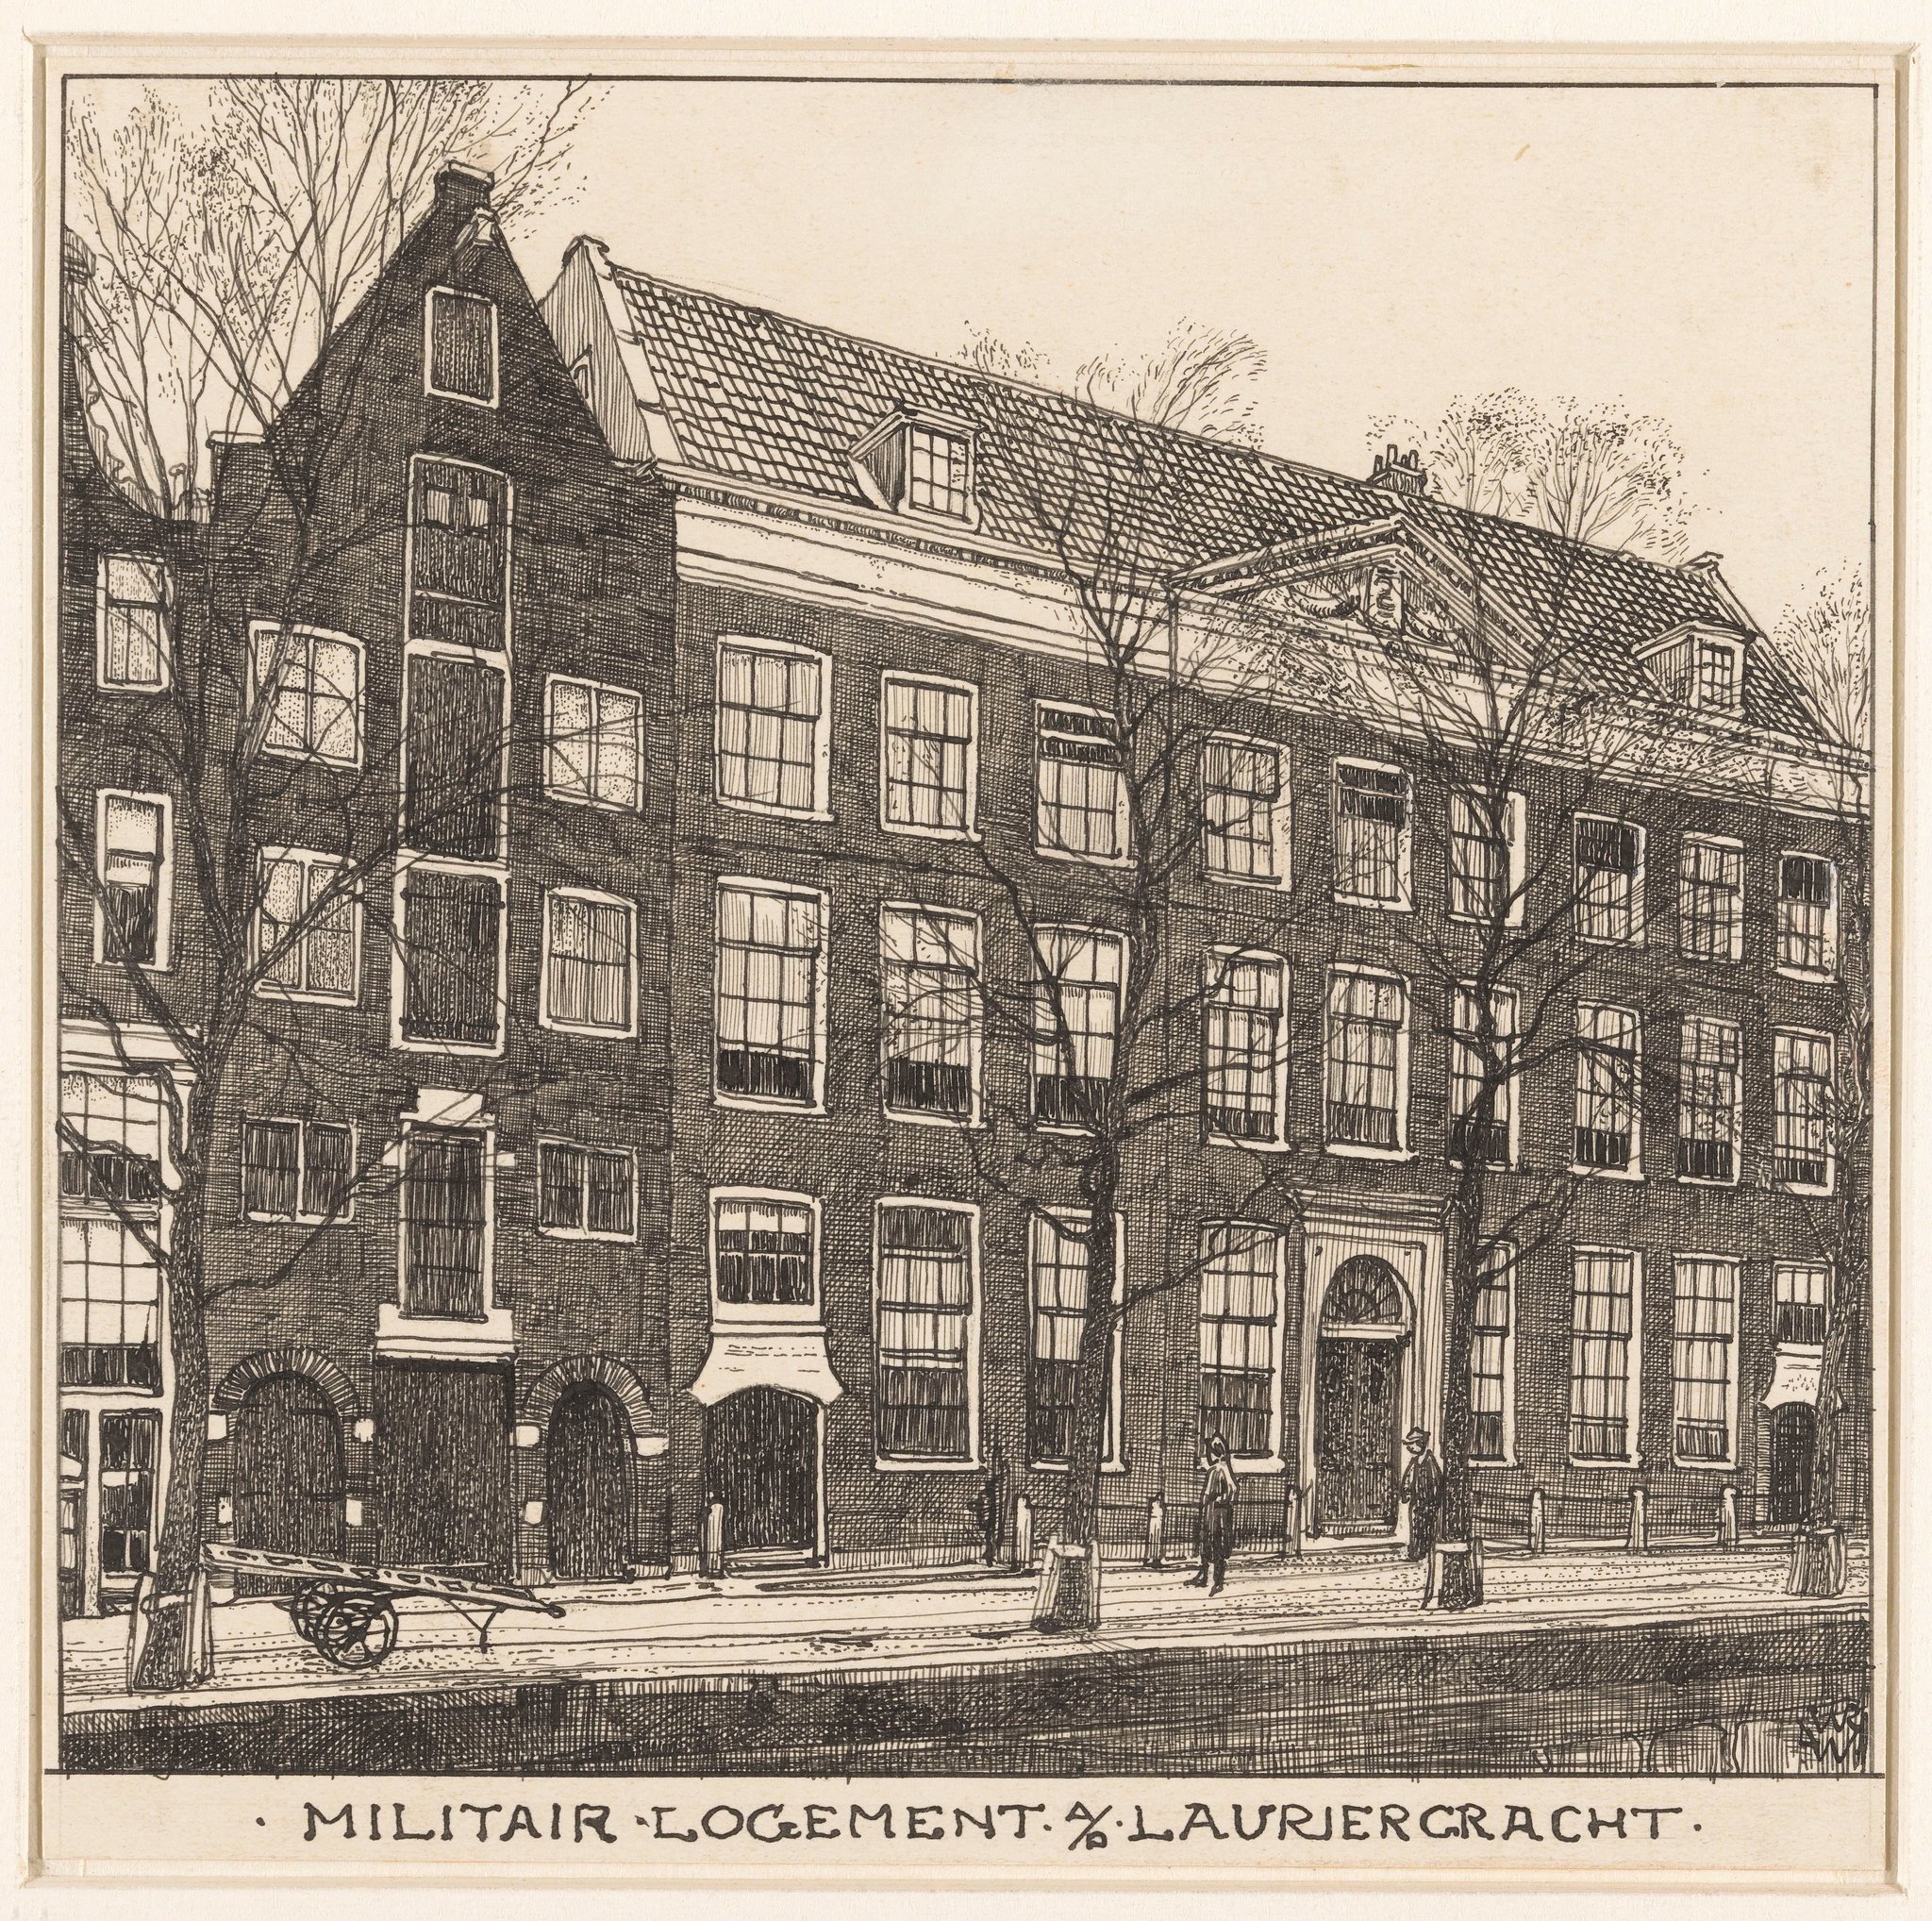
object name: drawing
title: Militair logement aan de Lauriergracht te Amsterdam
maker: willem wenckebach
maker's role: designer, draughtsman, painter, print maker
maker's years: 1860-1937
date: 1870-1926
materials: ink, paper, pencil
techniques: pen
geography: amsterdam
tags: canals, waters (in city)